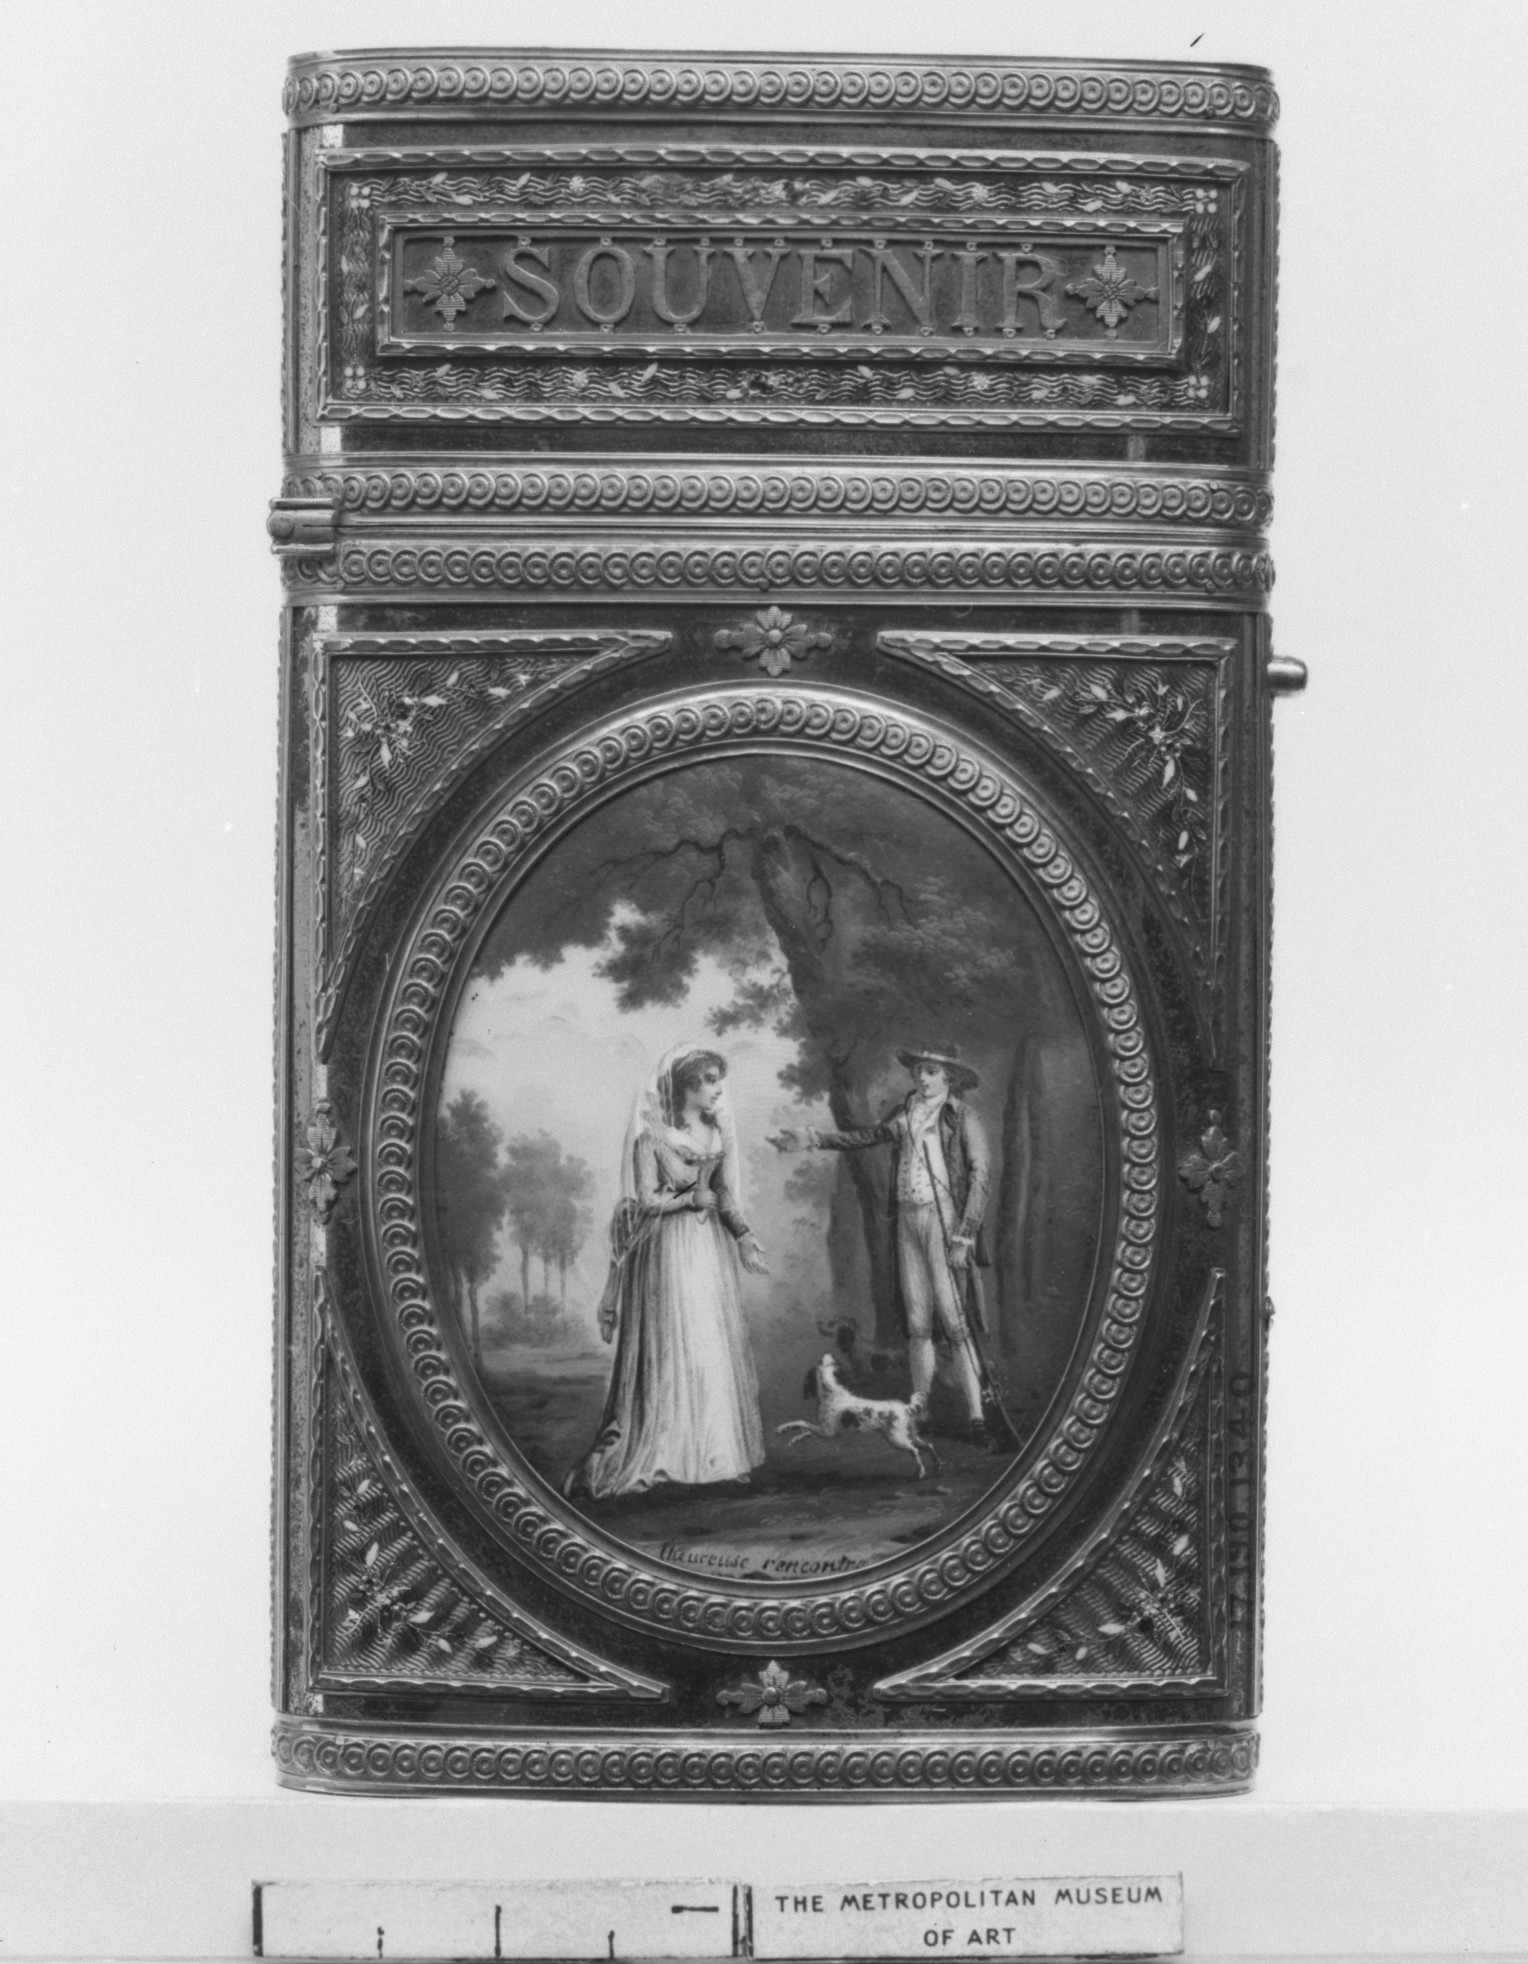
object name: souvenir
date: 1801-1900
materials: enamel, gold, steel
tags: firearms,men,women,dogs,flowers,trees